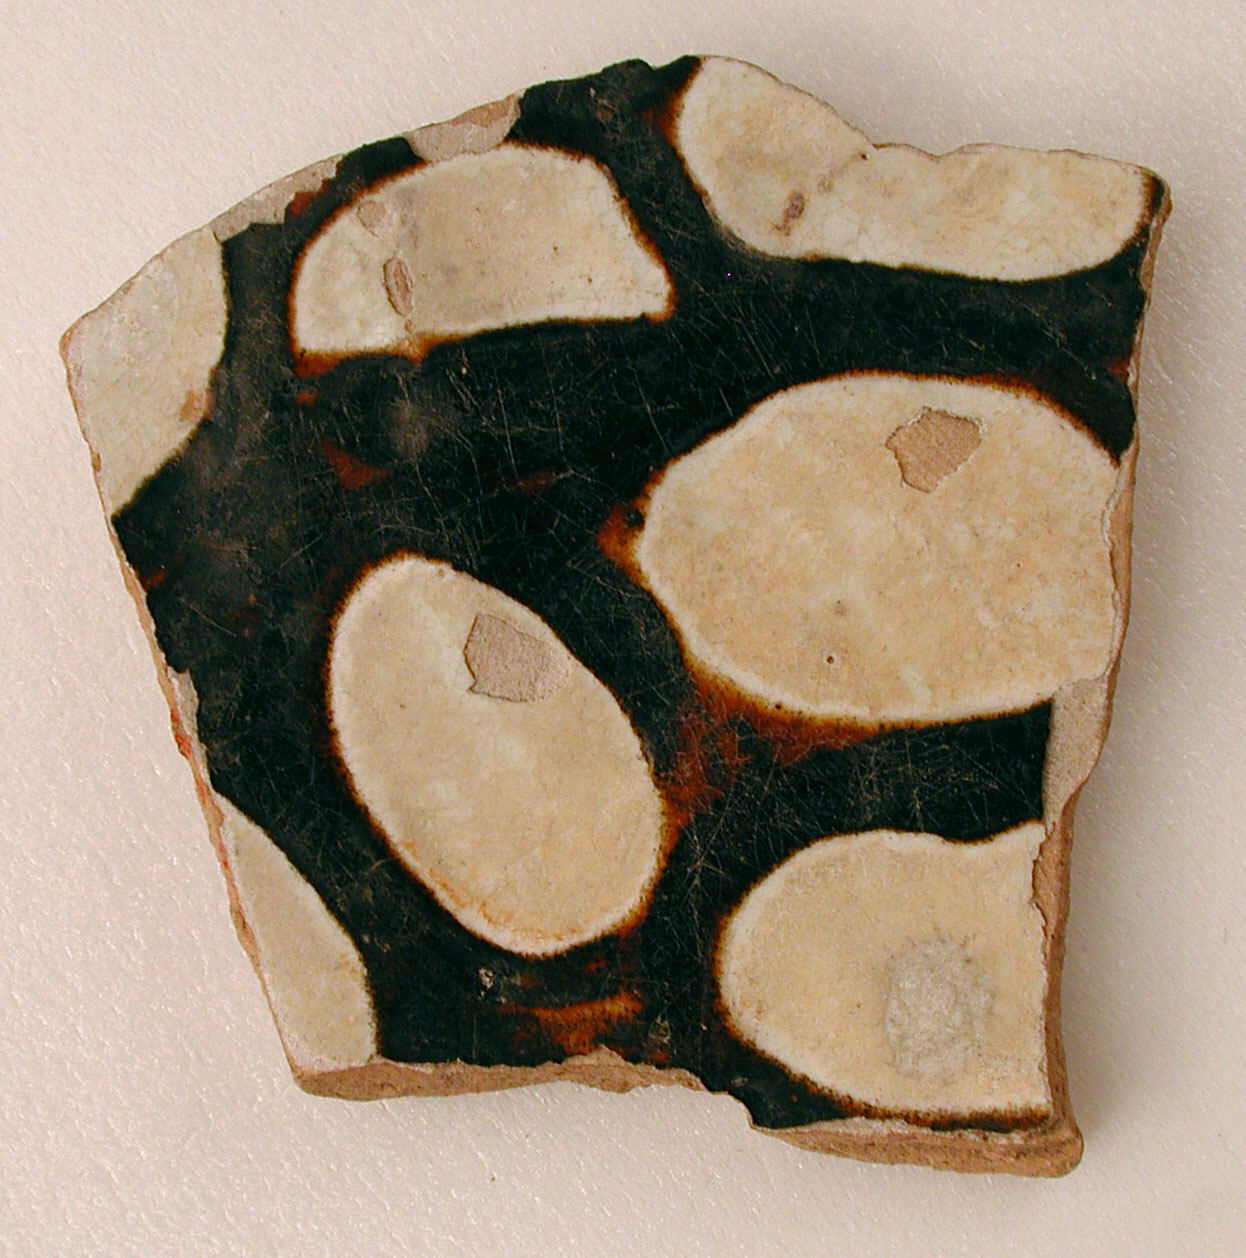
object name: fragment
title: Ceramic Fragment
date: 901-1000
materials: earthenware, glaze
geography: iran